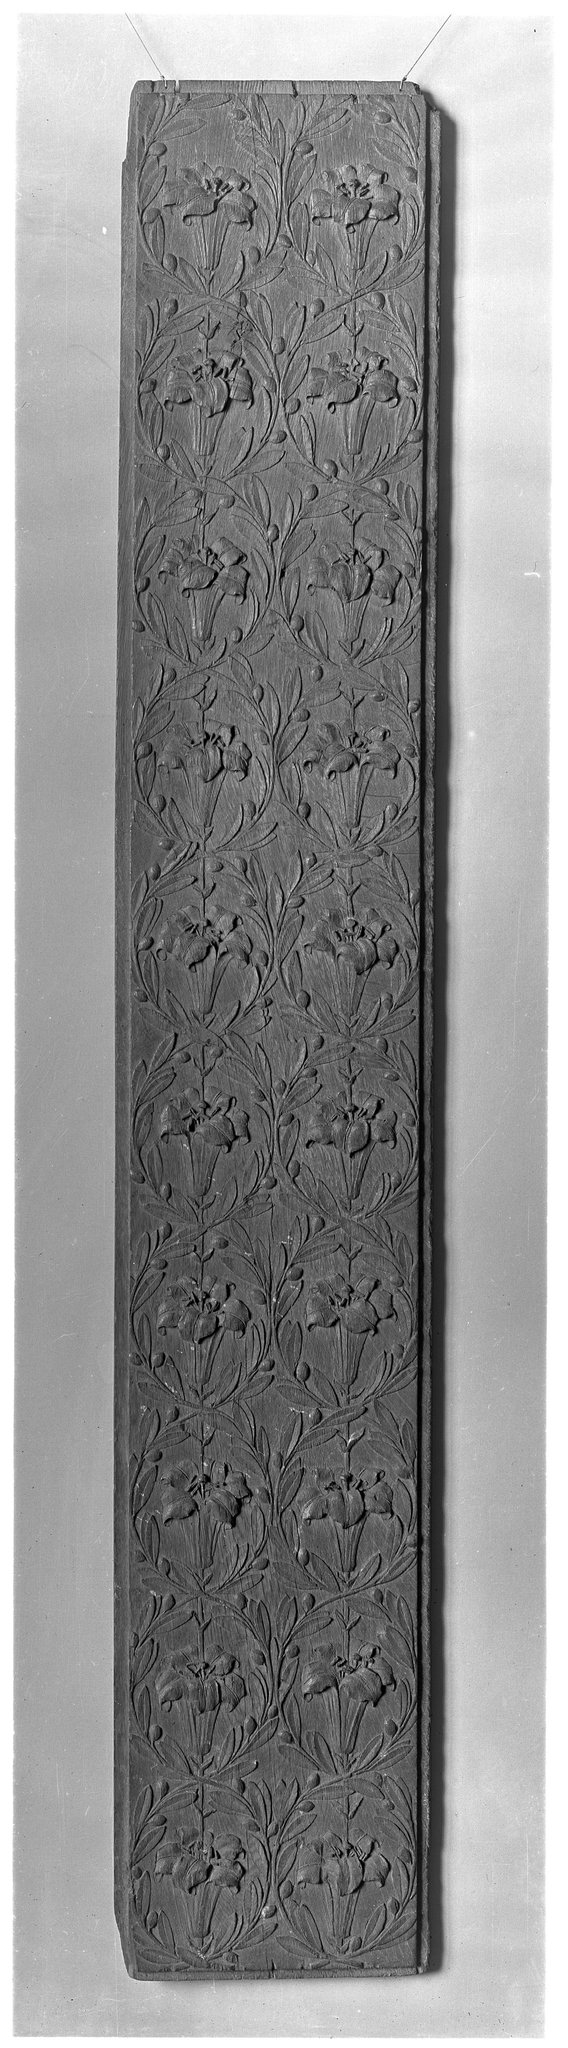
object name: panel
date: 1701-1800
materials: wood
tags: flowers,leaves